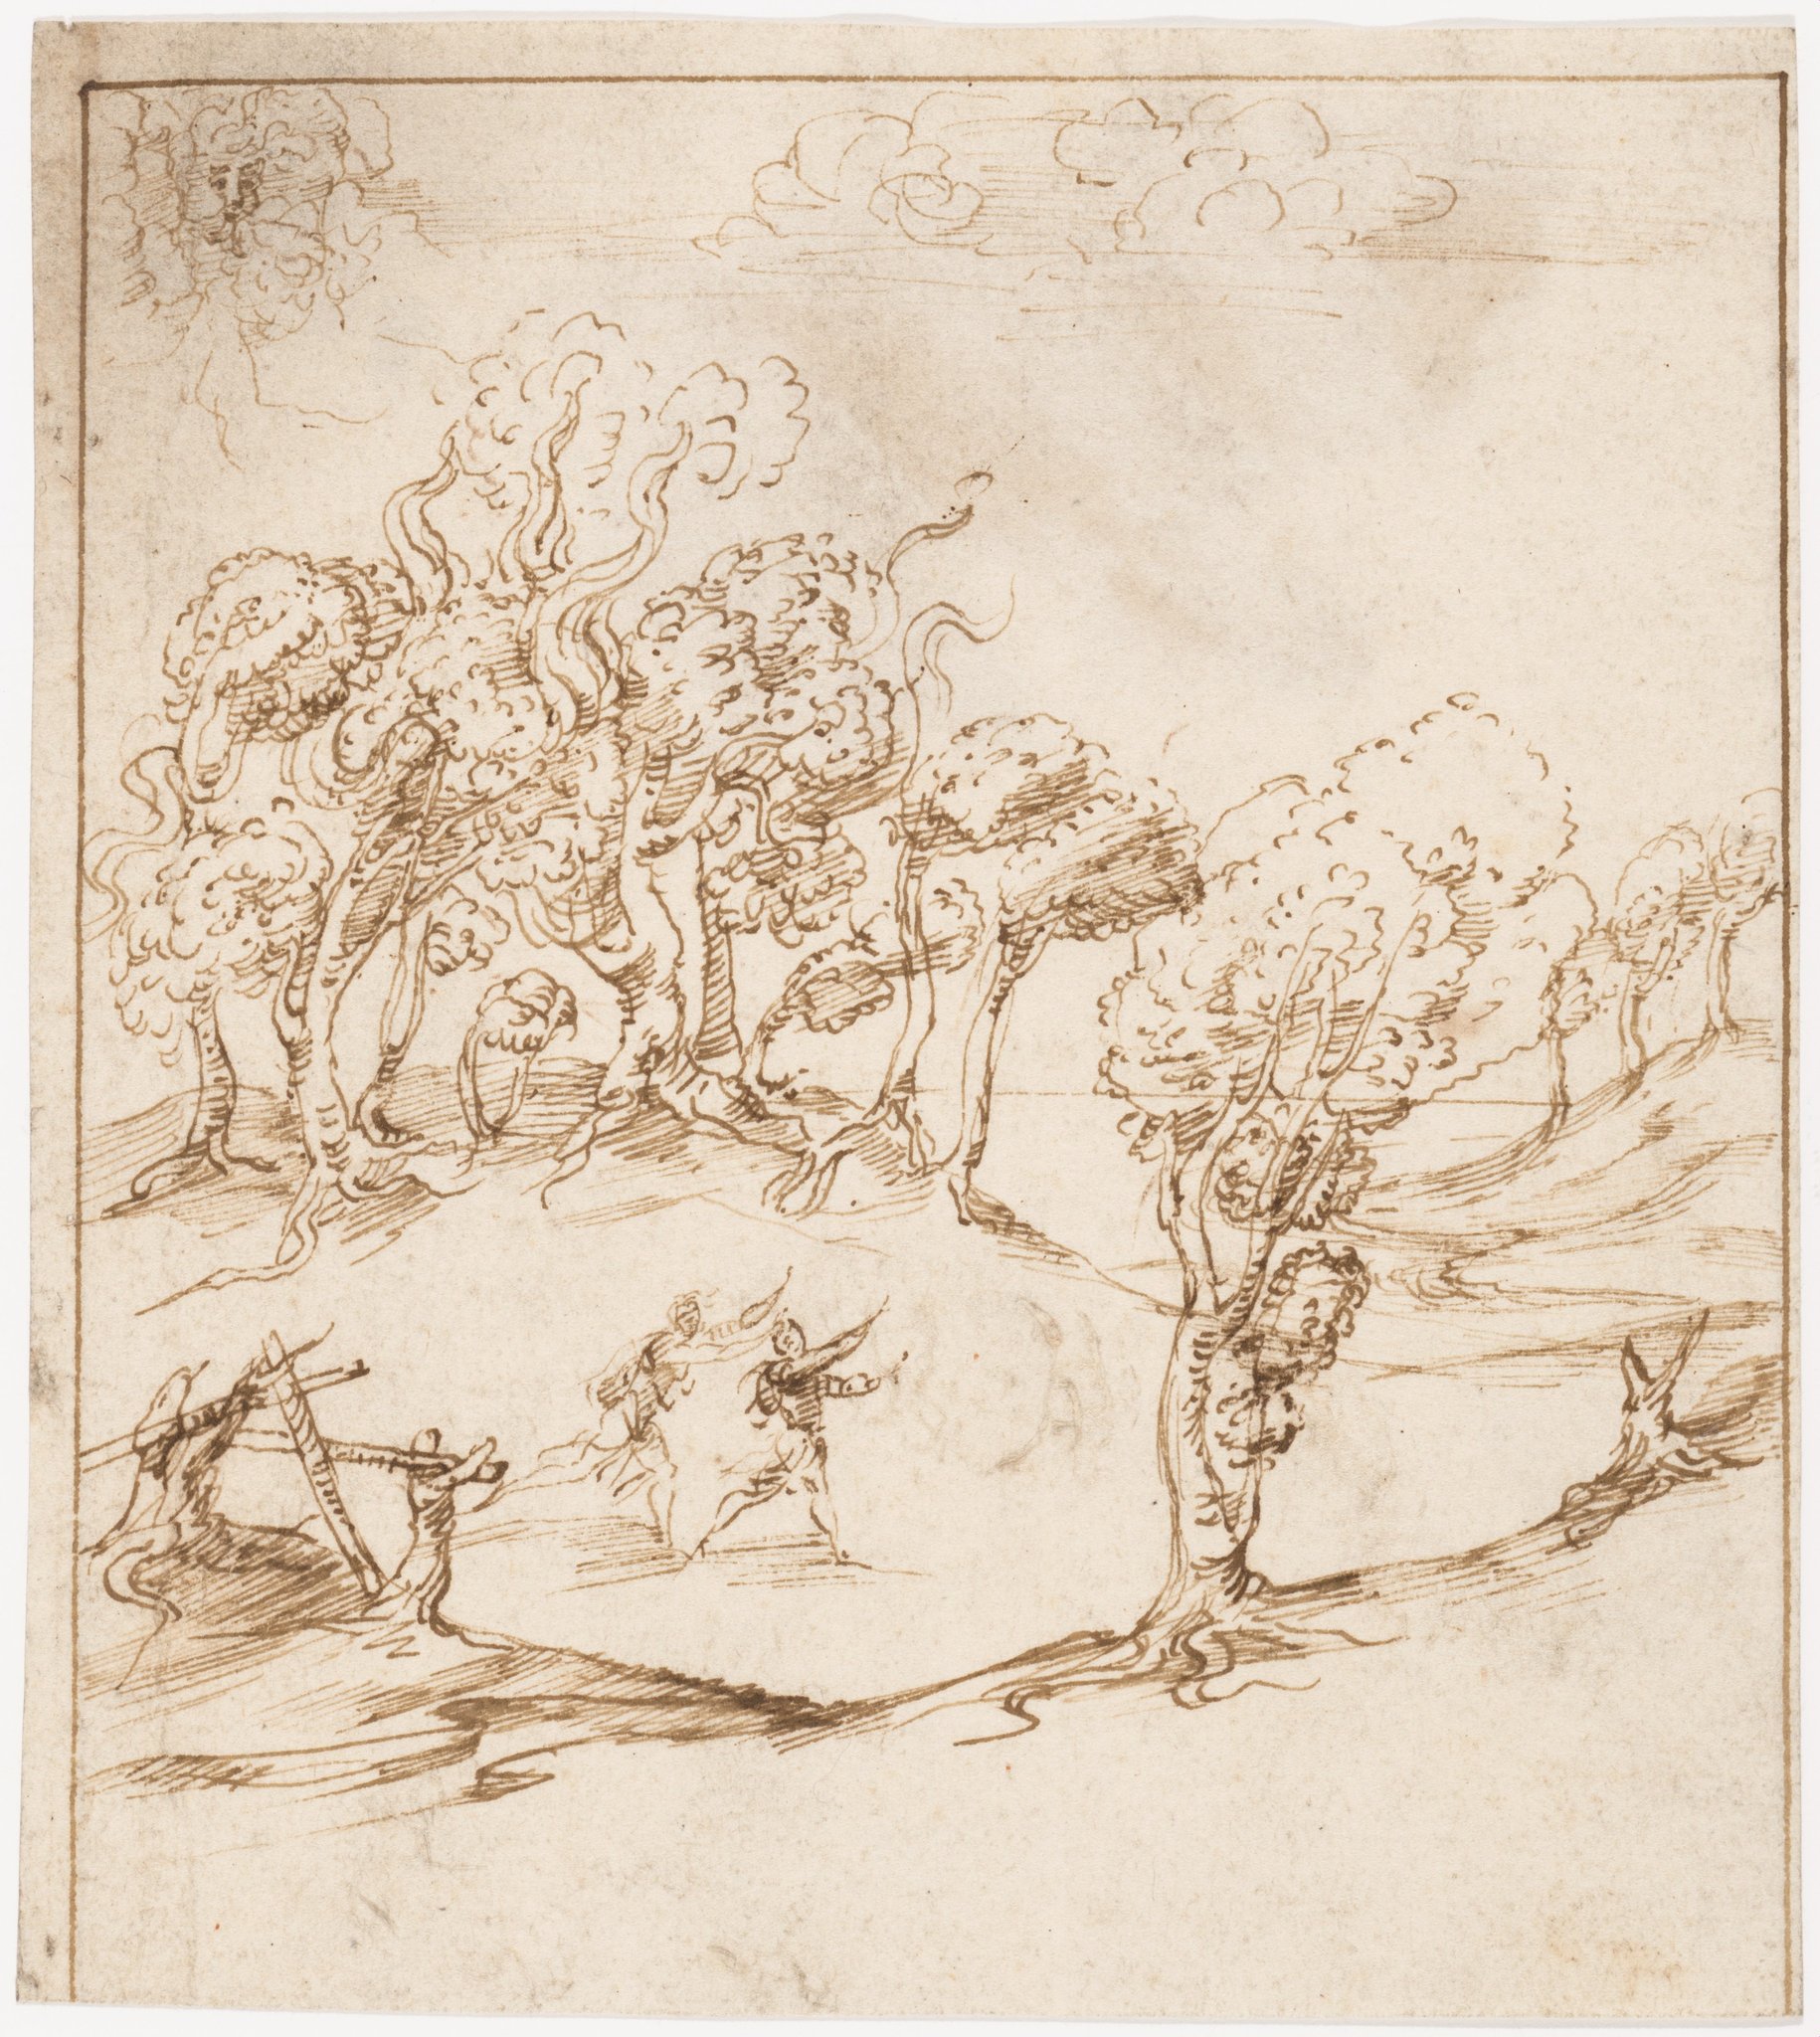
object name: drawing ornament architecture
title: Recto: Landscape with Trees and Figures (? Remarks on the Winds and the Lay-out of the City; Vitruvius, Book 1, Chapter 6, nos. 2, 3): Verso: Blank.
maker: sangallo family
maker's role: artist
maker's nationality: italian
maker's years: 1530-1545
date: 1530-1545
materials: ink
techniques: pen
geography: france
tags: men,trees